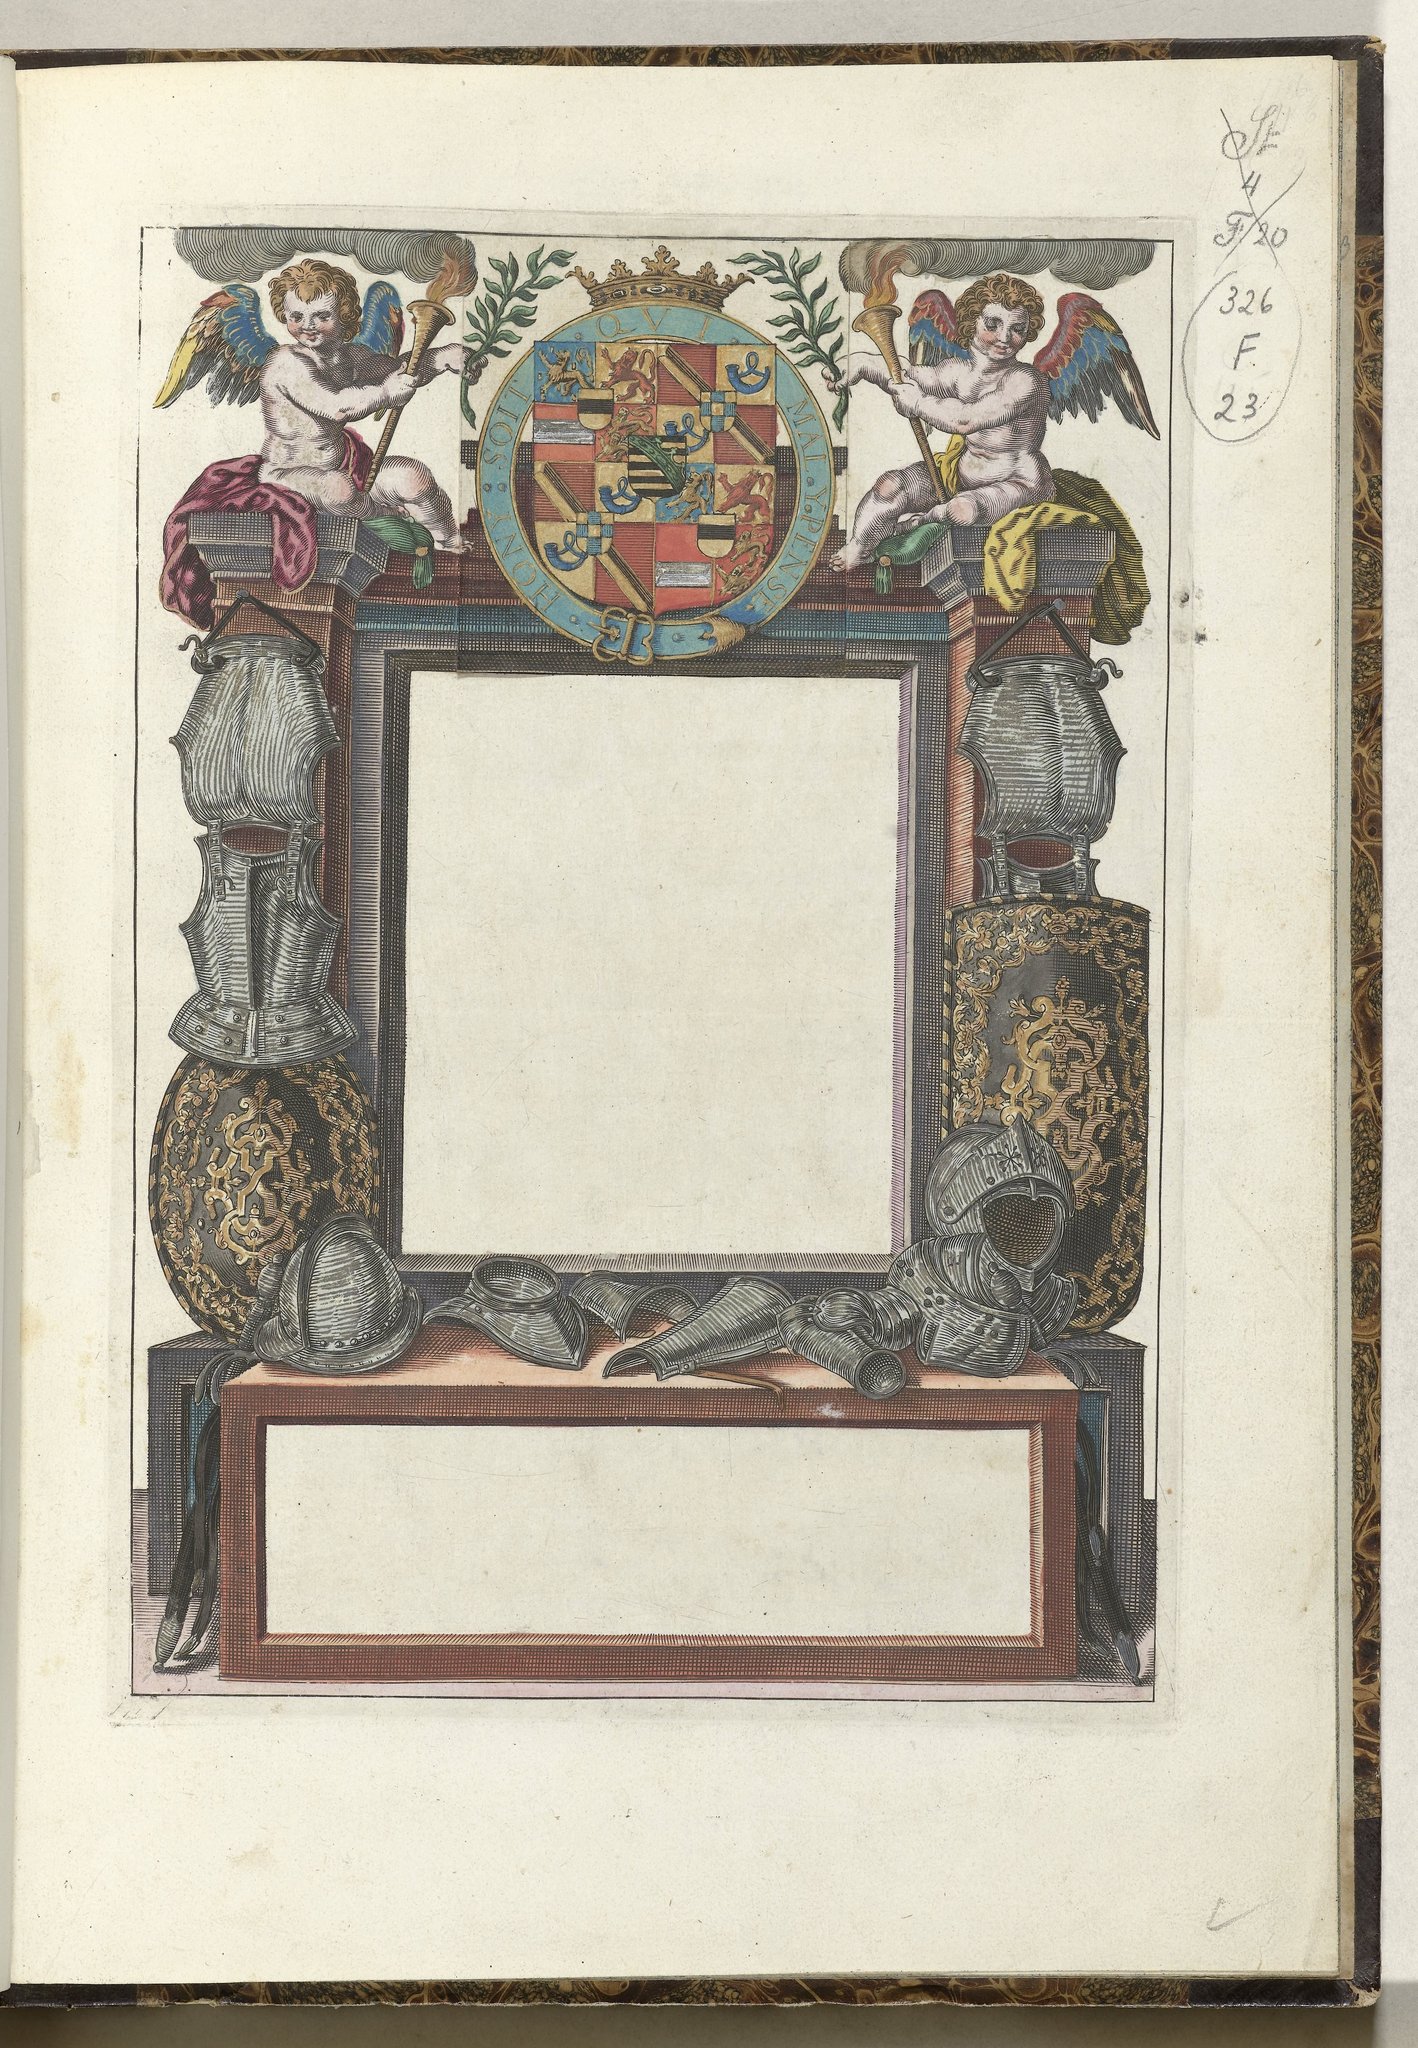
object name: titelblad, titelpagina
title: Titelpagina van een Duitse editie van Adam van Breens De Nassausche Wapen-Handelinge, 1618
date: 1616-1618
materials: paper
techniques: engraving, hand coloring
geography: northern netherlands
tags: maurice (prince of orange), armour, title-page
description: Illustratie in: Adam van Breen, Nassauische Waffenhandelung [incompleet exemplaar], 1618?, titelpagina. Dit is een Duitse editie van Adam van Breens De Nassausche Wapen-Handelinge, van Schilt, Spies, Rappier ende Targe : beyde figuerlick afgebeelt, ende gestelt na de nieu ordening [van] ... Maurits van Nassau, 's-Gravenhage, [Aert Meuris] 1618. In het exemplaar in de collectie van de Rijksmuseum Research Library (326 F 23).